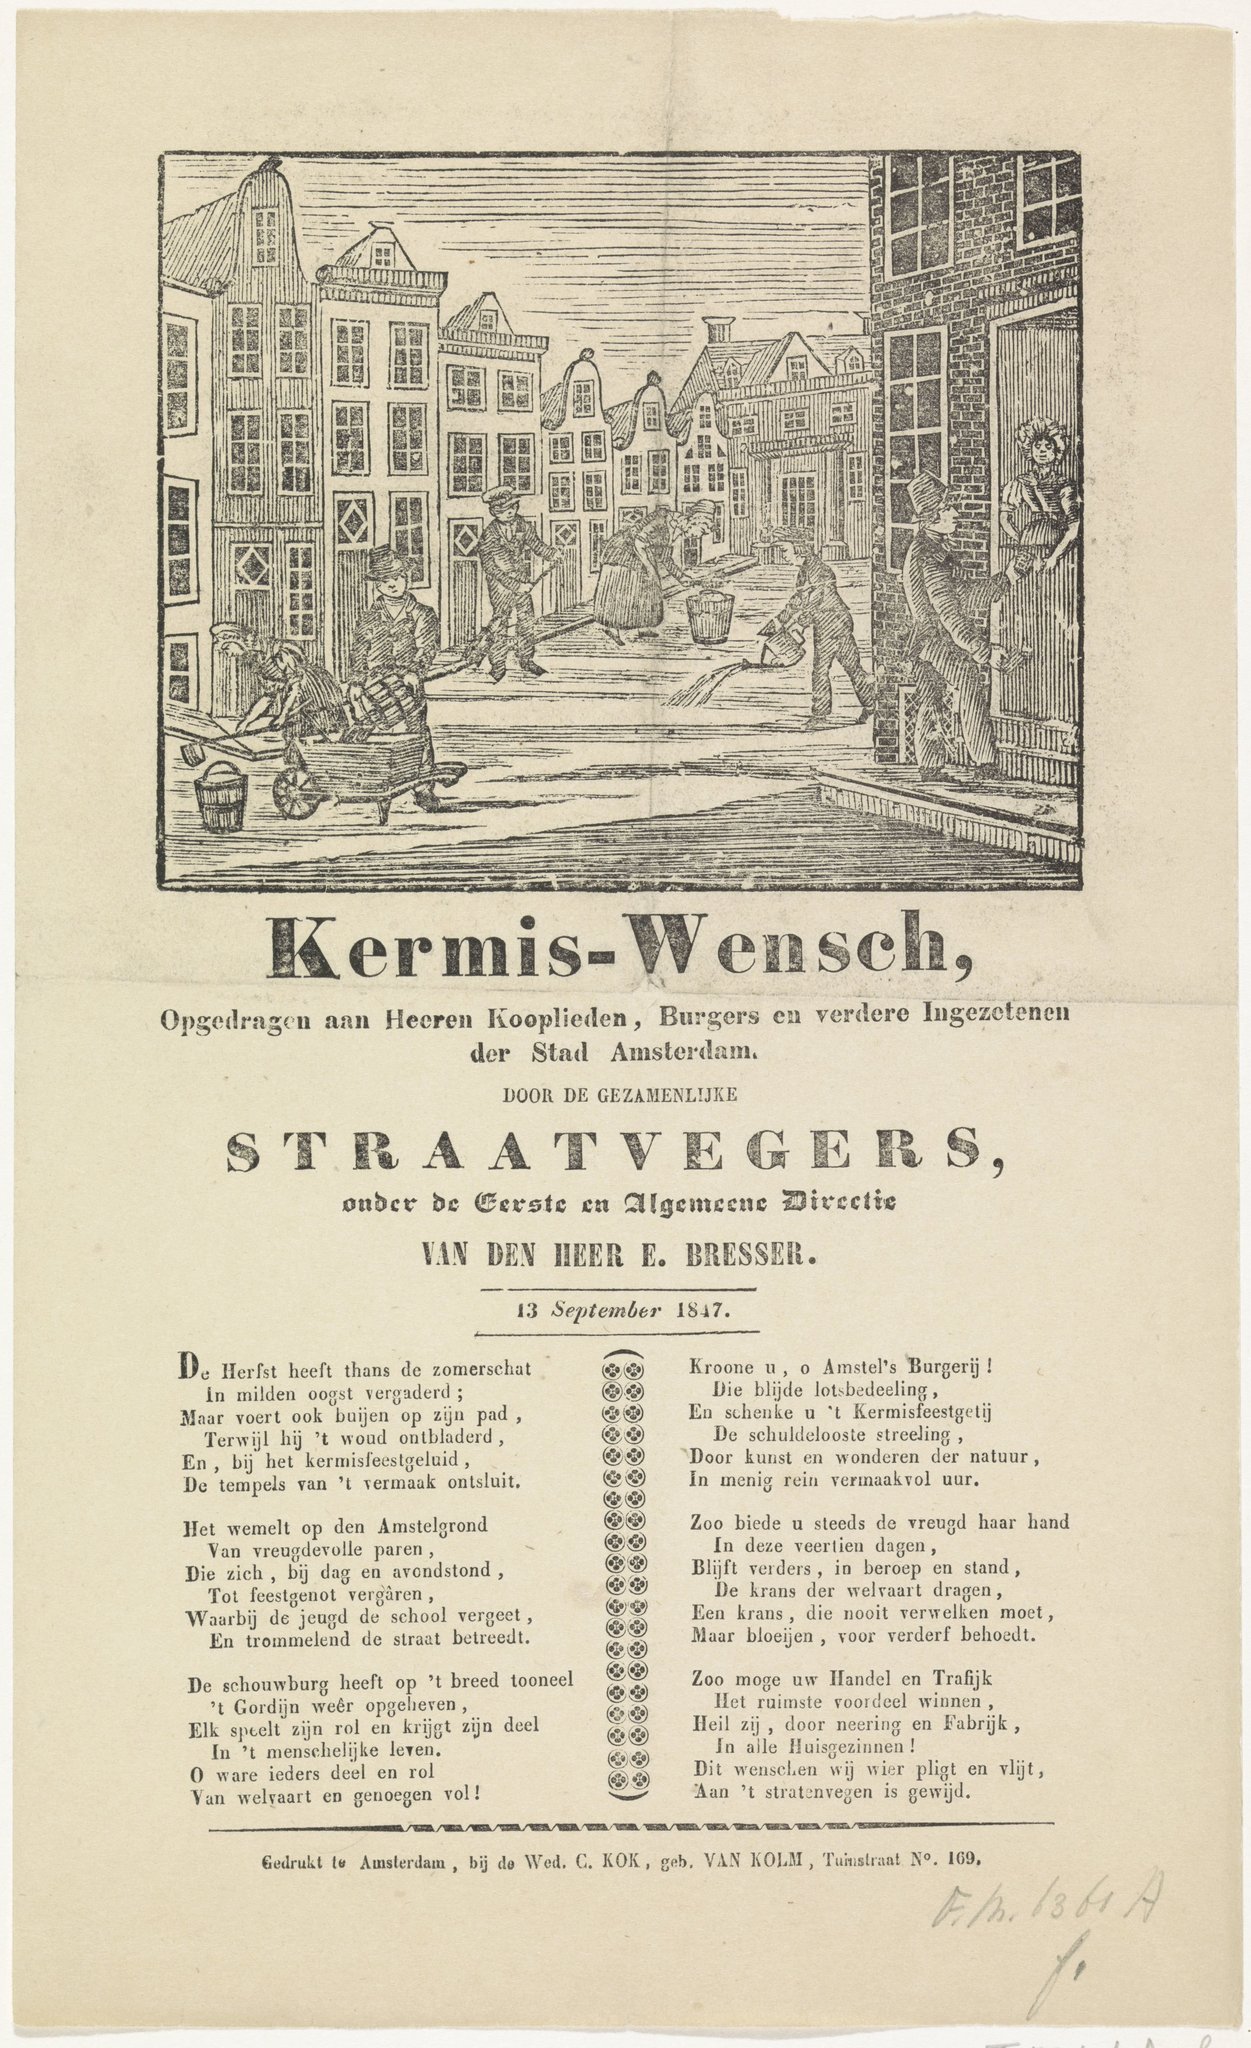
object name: print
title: Kermisprent van de Amsterdamse straatvegers, 1847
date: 1847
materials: paper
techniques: letterpress printing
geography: amsterdam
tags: street - ii - ideal city, street sweeping, street sweeper, amsterdam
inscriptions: collector's mark: Lugt 2228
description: Kermisprent van de Amsterdamse straatvegers, 13 september 1847. Gezicht in een Amsterdamse straat waar meerdere mannelijke en vrouwelijke stratenvegers aan het werk zijn, op de voorgrond haalt een man geld op bij een huis. Met een vers in twee kolommen.